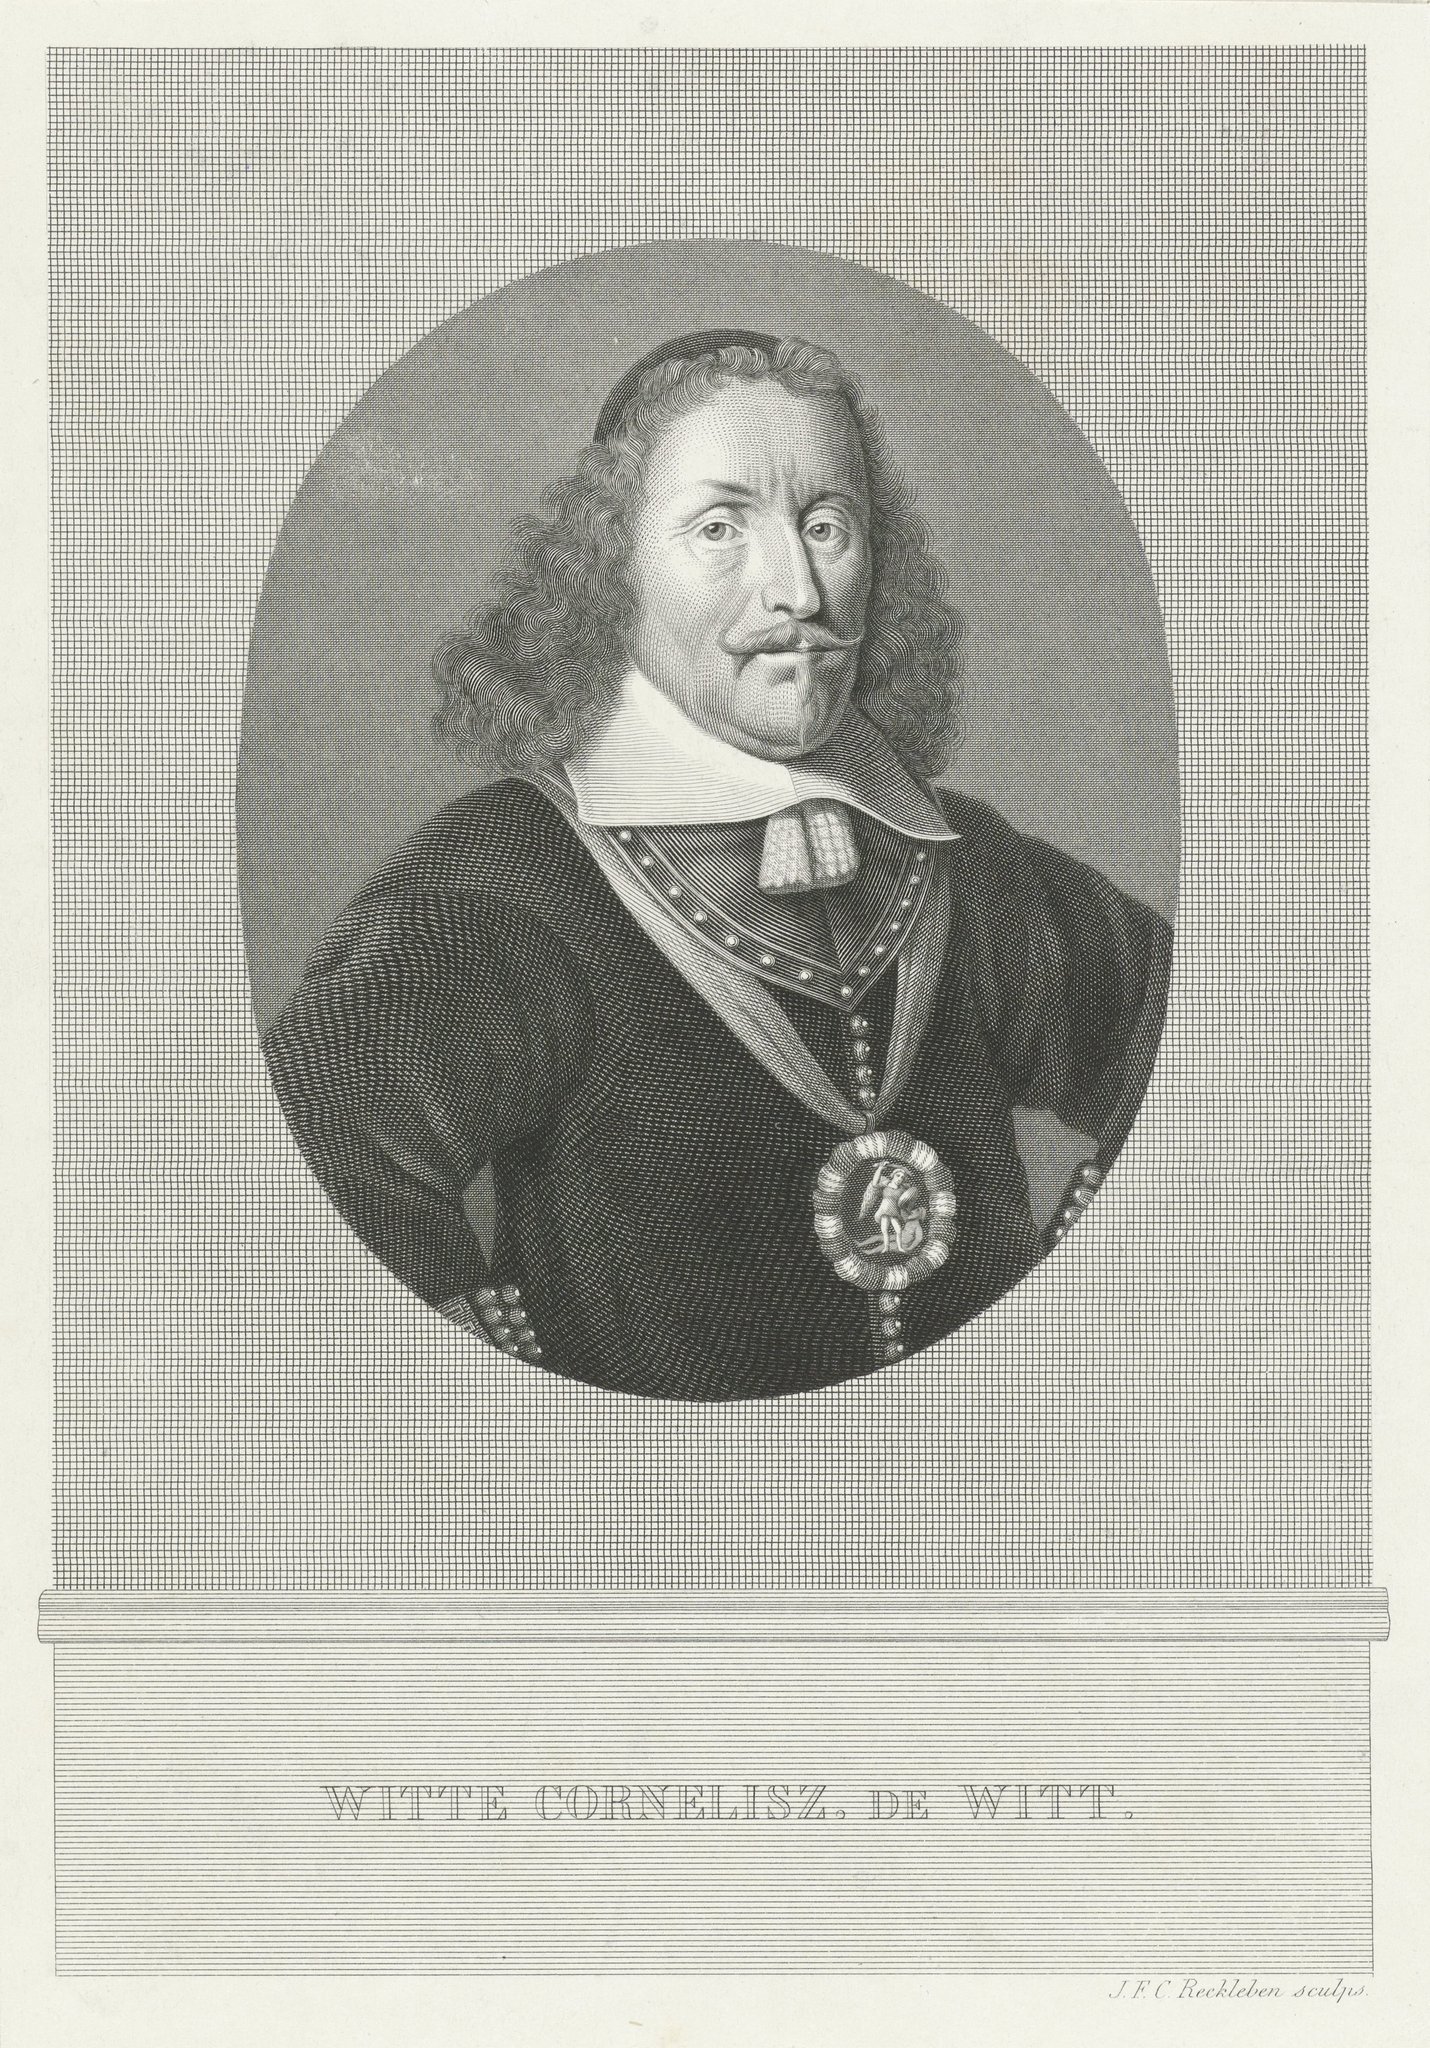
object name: print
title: Portret van Witte Cornelisz. de With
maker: jan frederik christiaan reckleben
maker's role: print maker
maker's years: 1819-1879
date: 1866-1868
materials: paper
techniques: engraving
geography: amsterdam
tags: hoogendijk, zeeofficier, witte cornelisz. de with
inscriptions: collector's mark: Lugt 2228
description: Portret van de marine-admiraal Witte Cornelisz. de With. Hij draagt om zijn nek een medaillon met een engel die een duivel verslaat, het draagteken van de Orde van Saint Michel, waarvan ook Michiel de Ruyter lid was. Op de plint zijn naam.